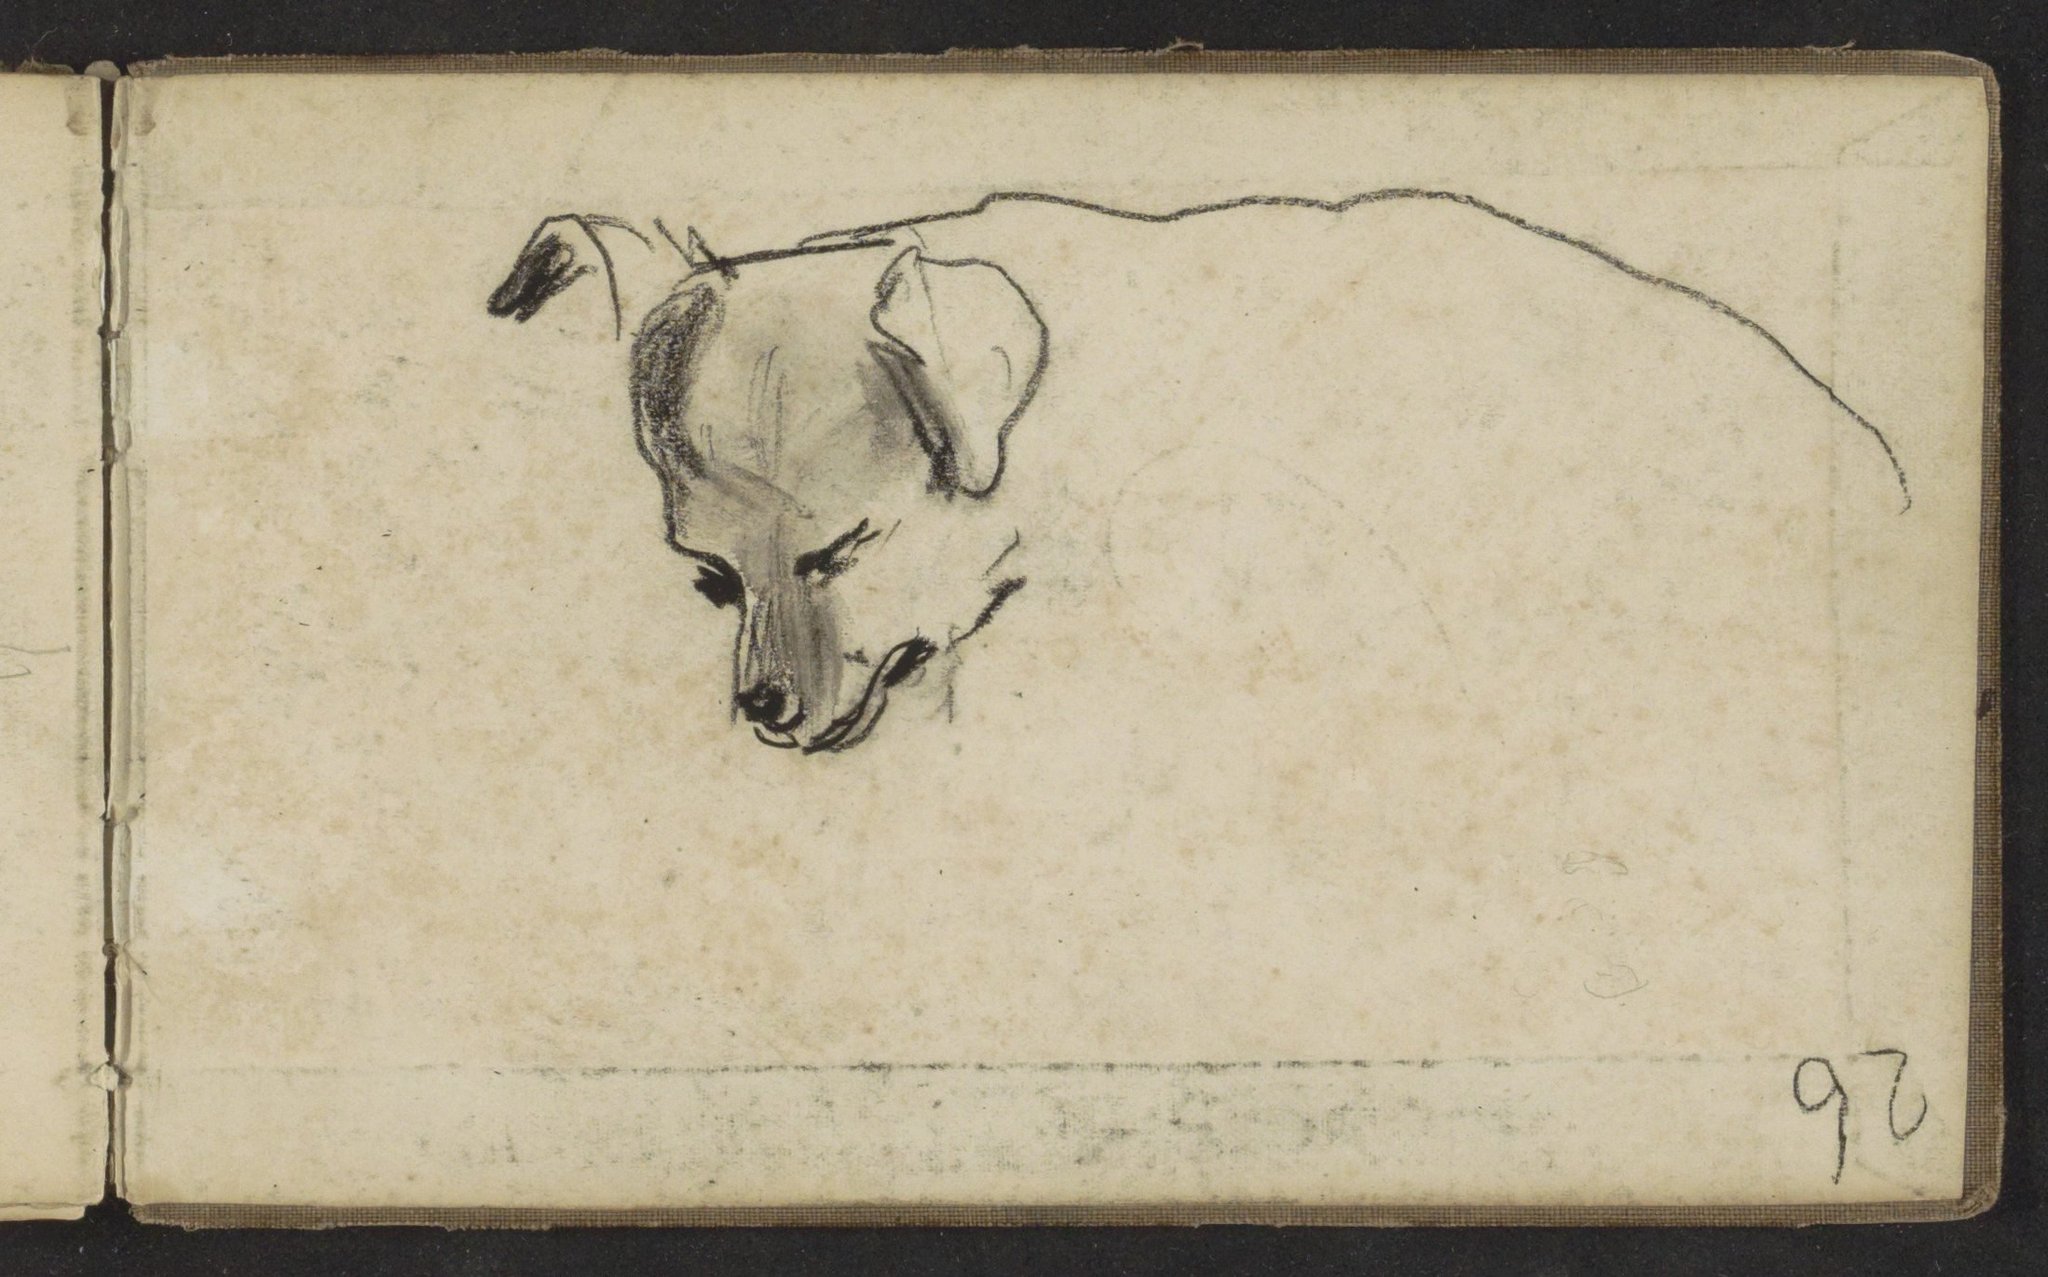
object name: endleaf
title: Hond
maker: johan hendrik weissenbruch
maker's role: draughtsman, painter, print maker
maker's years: 1824-1903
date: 1834-1903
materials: chalk, paper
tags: dog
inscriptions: number: ‘26’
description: Achterste schutblad uit een schetsboek met 43 bladen.